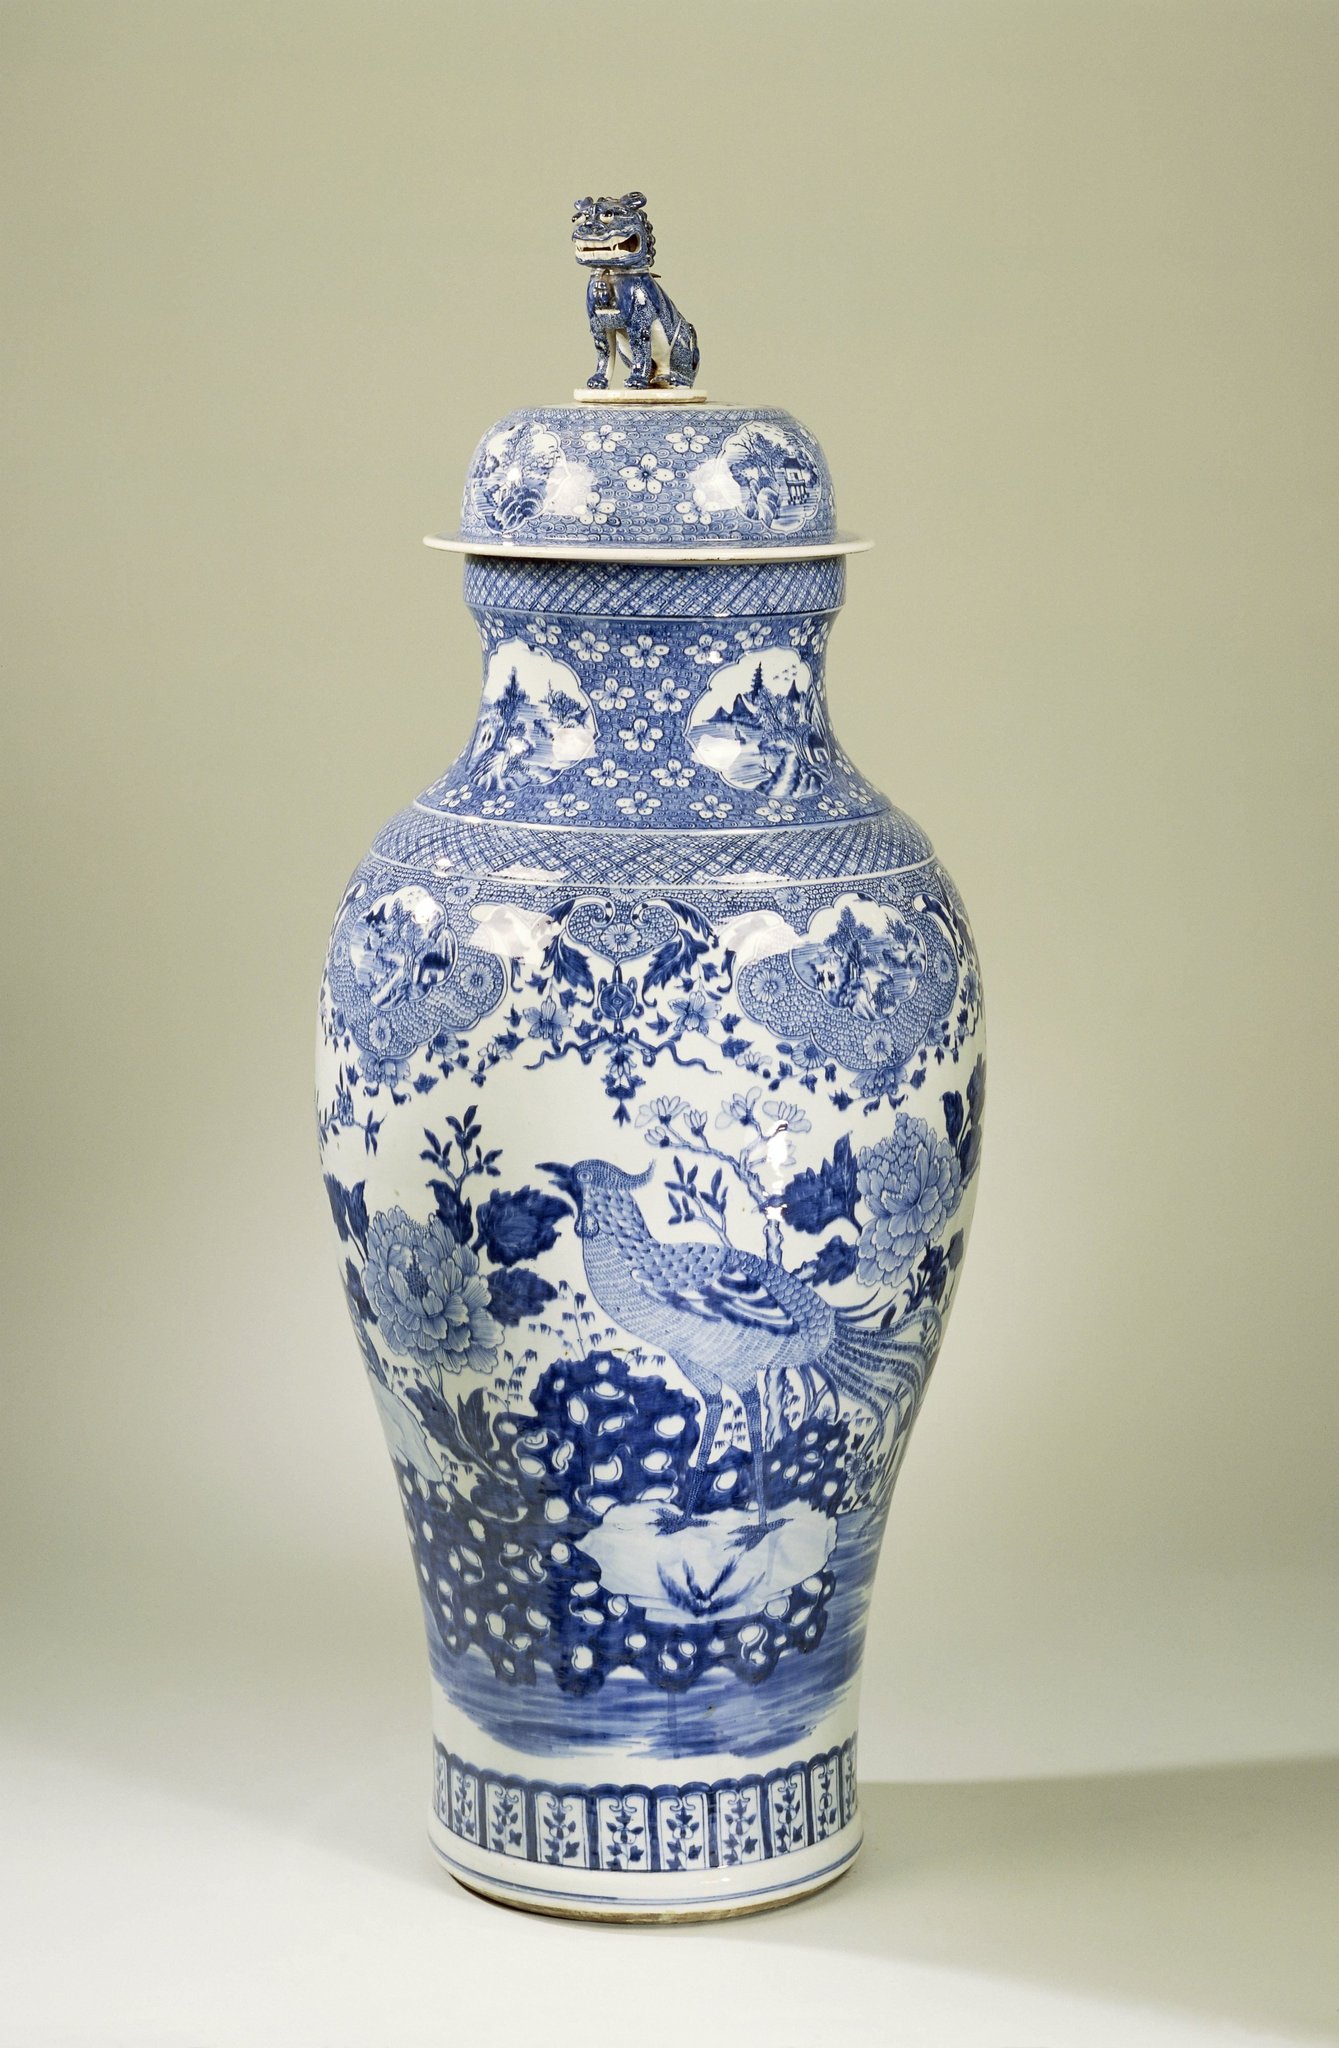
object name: covered jar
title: Baluster covered jar with pheasants on a rock near flowering plants and landscapes in panels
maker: Anonymous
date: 1750-1780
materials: cobalt, glaze, paint, porcelain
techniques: firing, forming, turning, vitrification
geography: china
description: Only the very wealthy could order vases of such enormous proportions, like this one, from China. They were genuine status symbols and usually produced in pairs to enhance the dramatic effect. On the lid is a lion, which in China brings luck and is a symbol of protection.